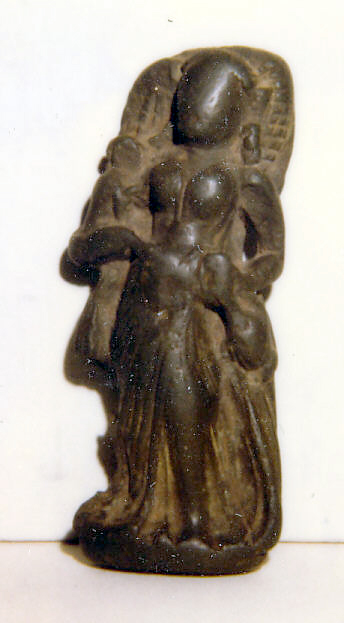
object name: mirror handle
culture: kashmiri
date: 501-800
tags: kashmir